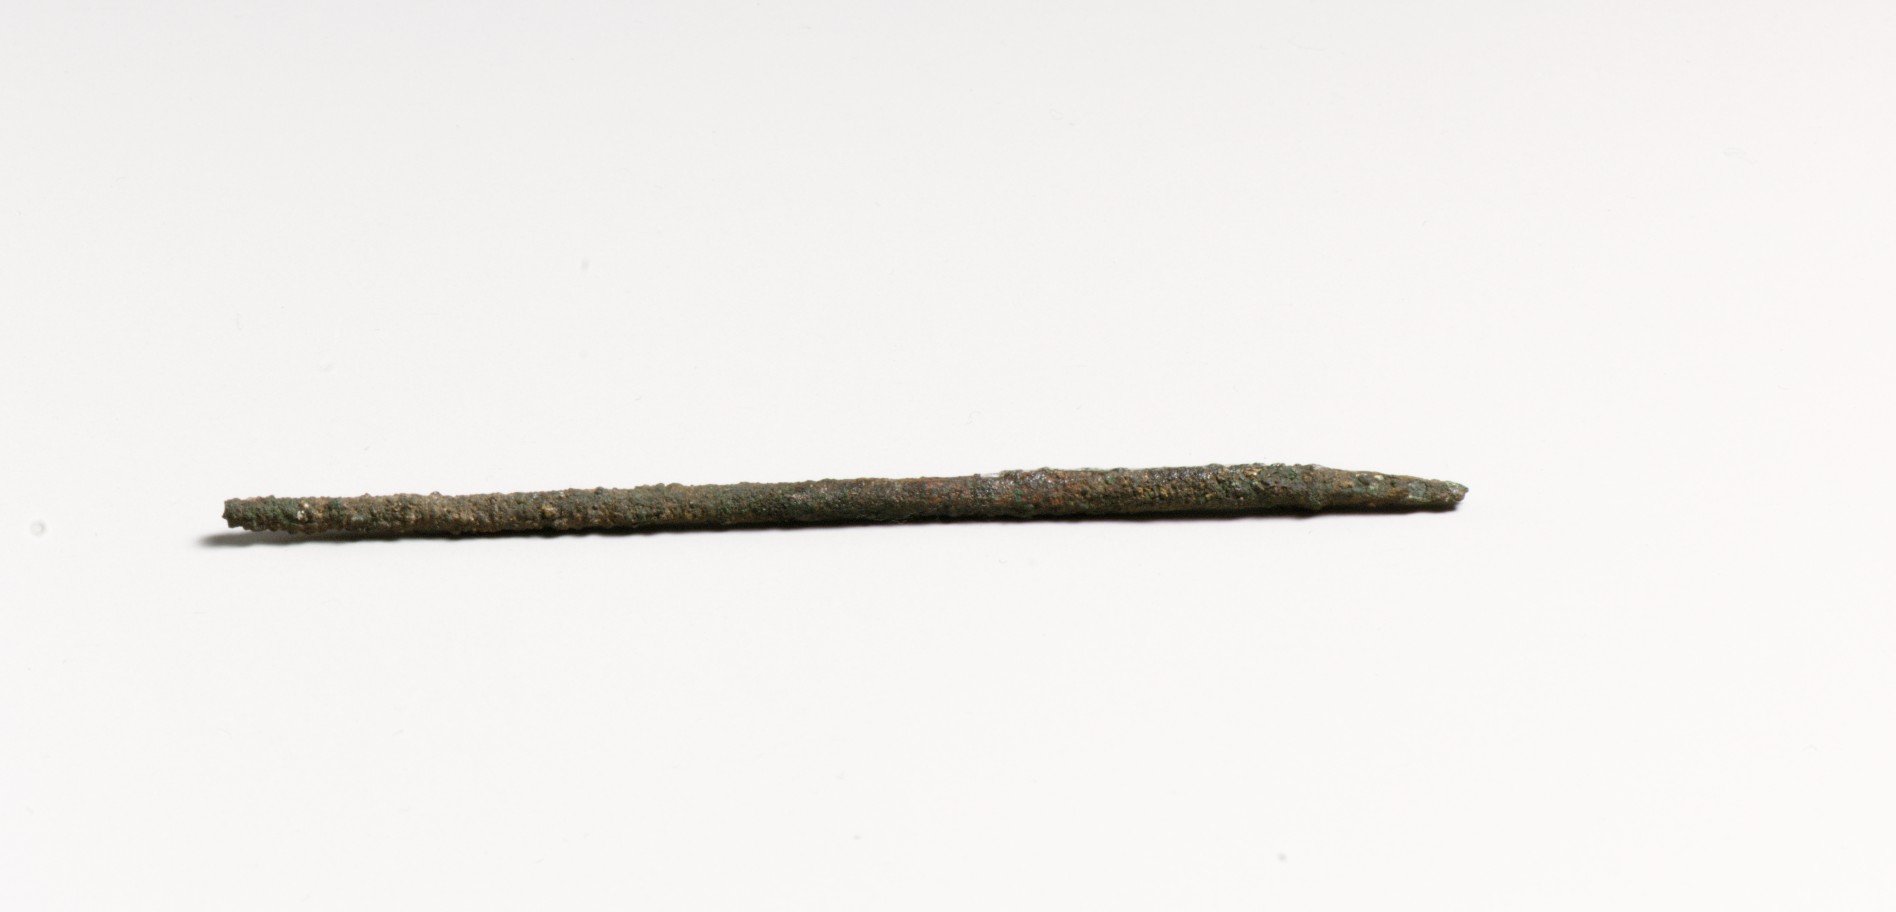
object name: awl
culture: cypriot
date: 3900 BCE-100 CE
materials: bronze